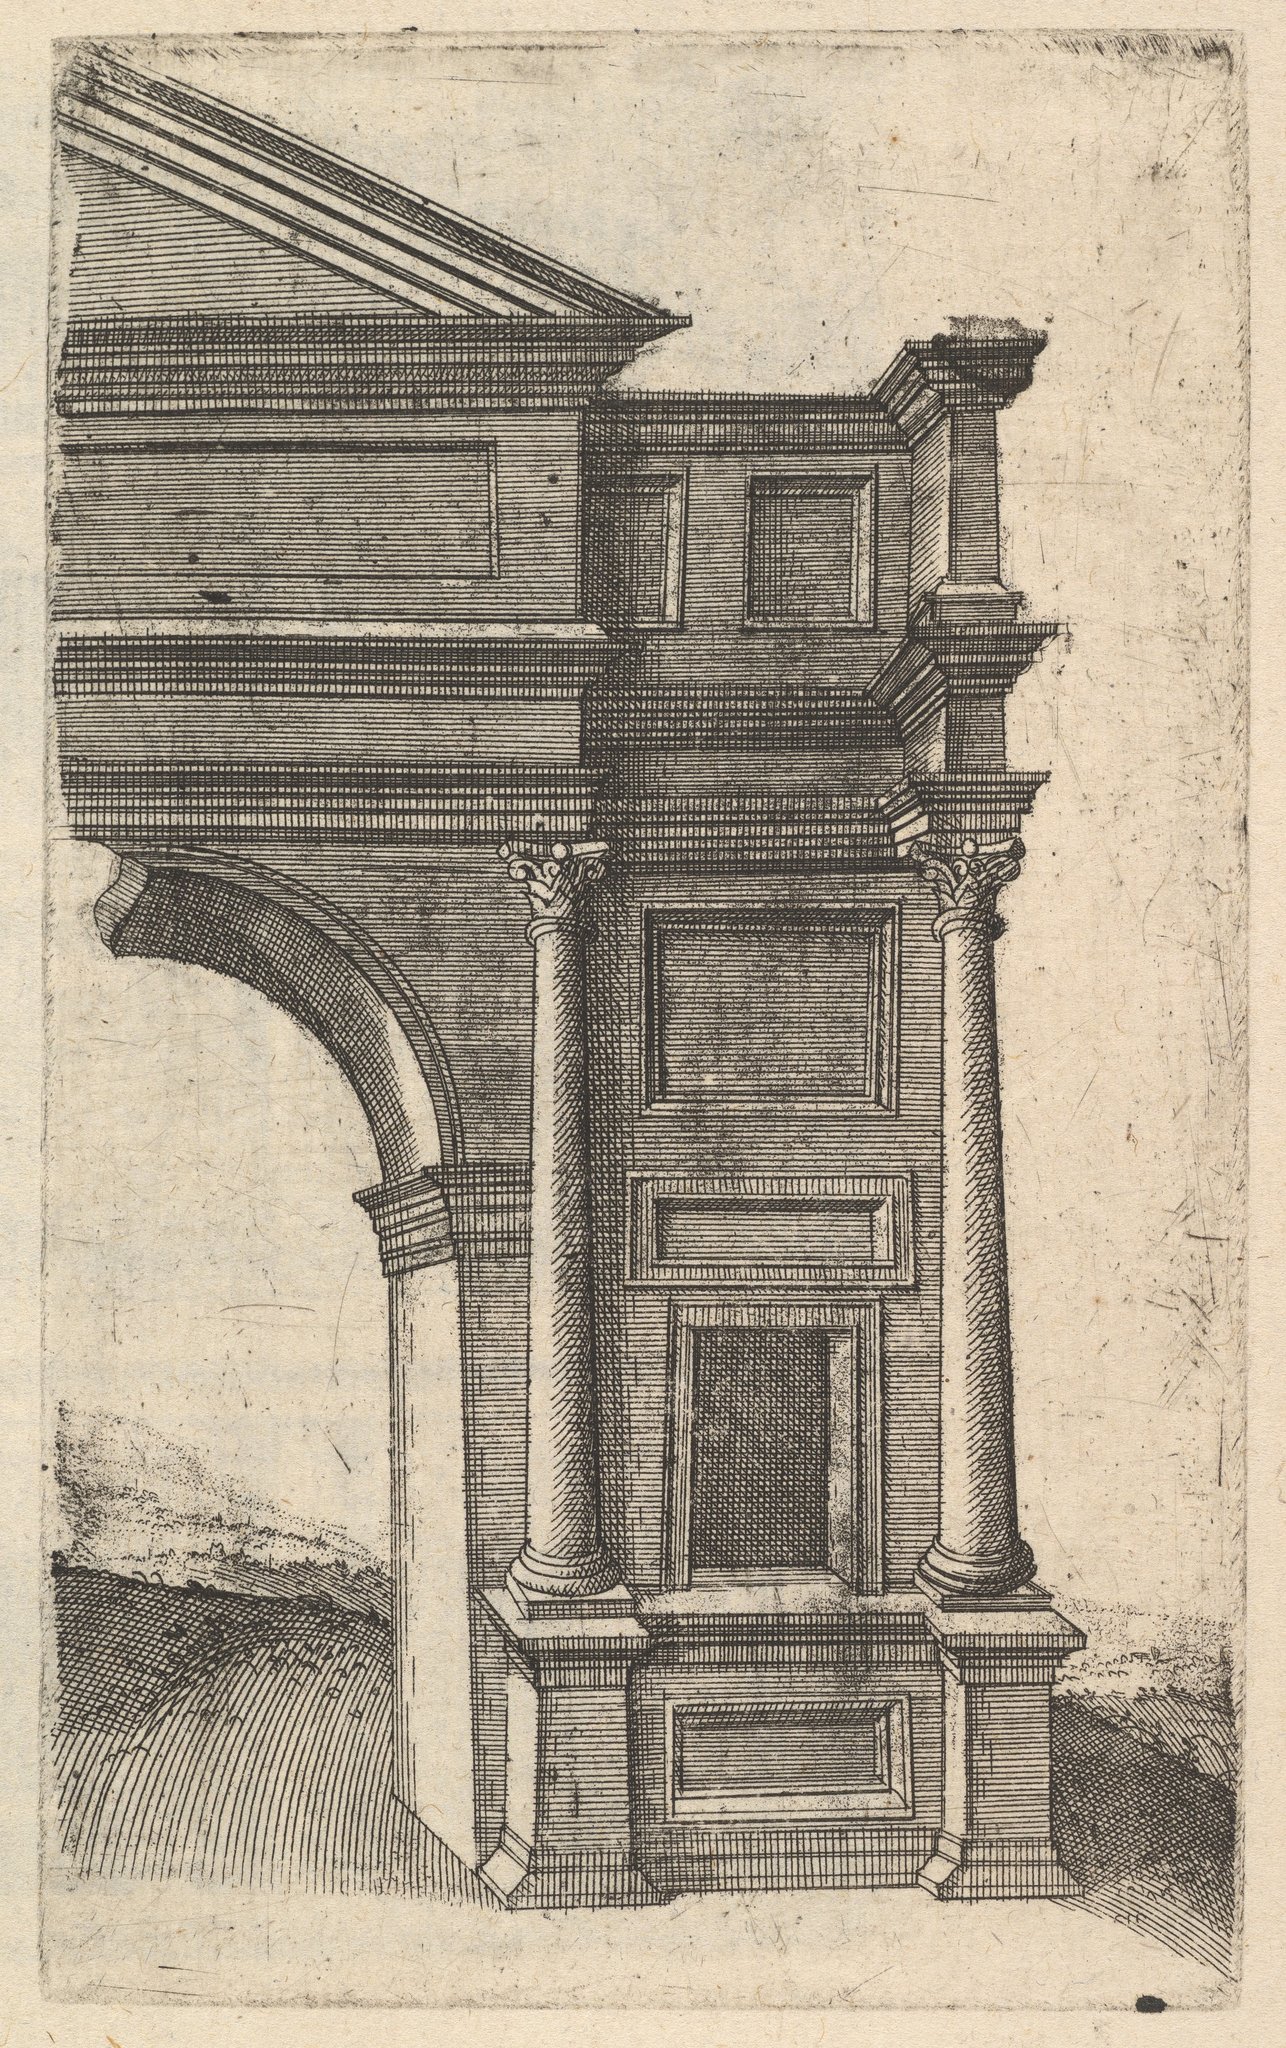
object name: book print ornament architecture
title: Half of an Arch [Porta Antonae] from the series 'Ruinarum variarum fabricarum delineationes pictoribus caeterisque id genus artificibus multum utiles'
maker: lambert suavius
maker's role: artist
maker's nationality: netherlandish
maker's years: 1510-1576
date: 1554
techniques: etching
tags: architecture,arches